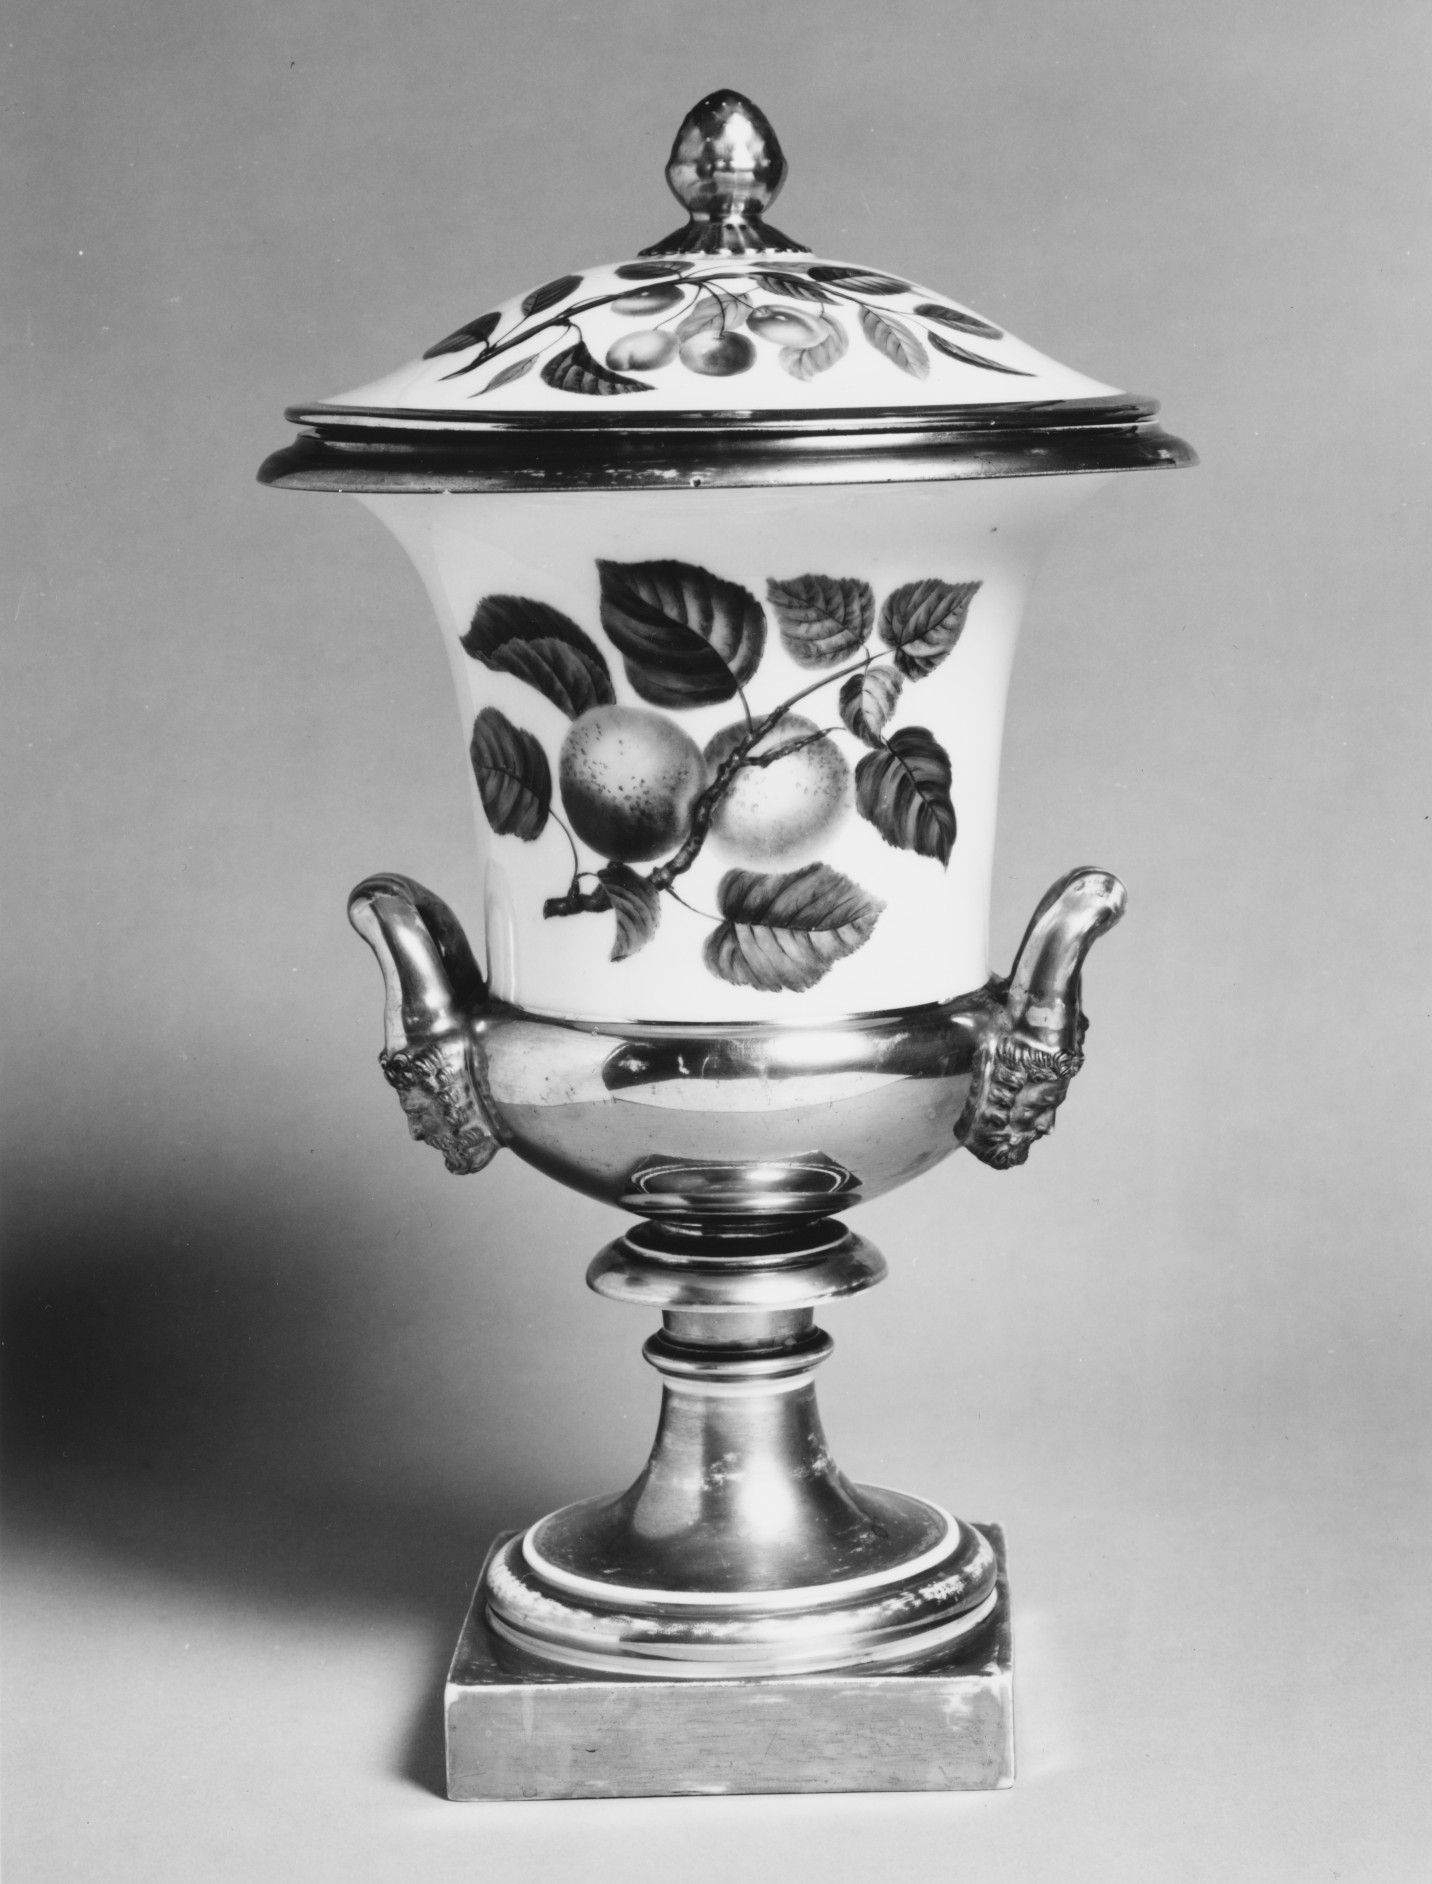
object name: urn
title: Covered Urn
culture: french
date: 1816-1823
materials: porcelain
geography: rotorua whakarewarewa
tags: fruit